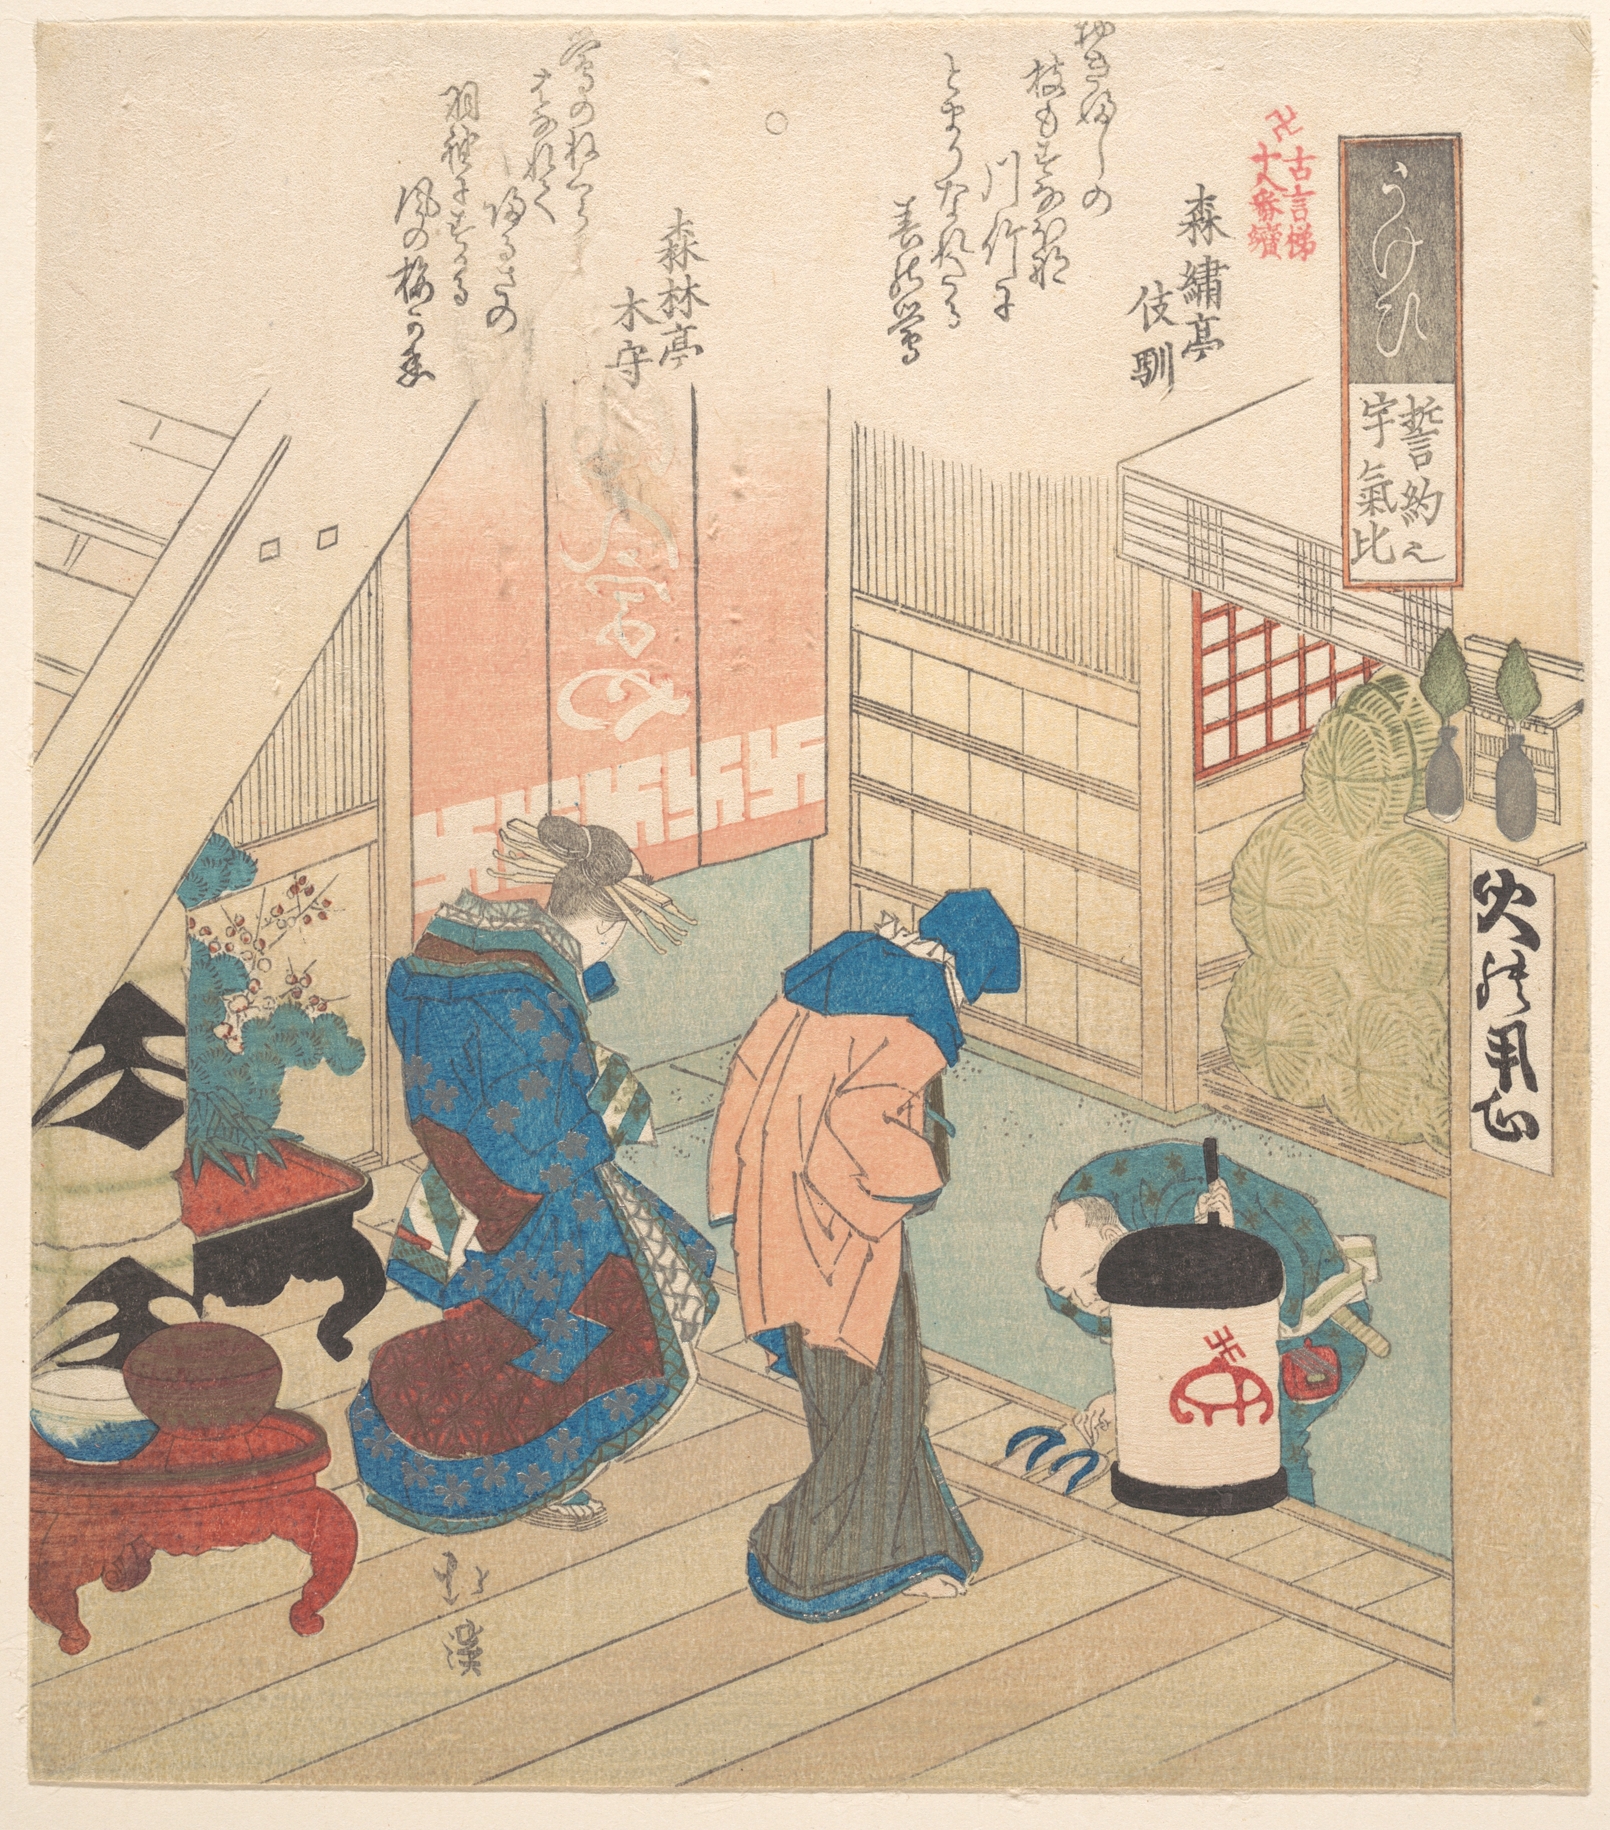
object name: print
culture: japanese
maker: totoya hokkei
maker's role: artist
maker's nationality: japanese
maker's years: 1780-1850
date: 1780-1850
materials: ink, paper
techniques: surimono, woodblock print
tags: men,women,tea houses